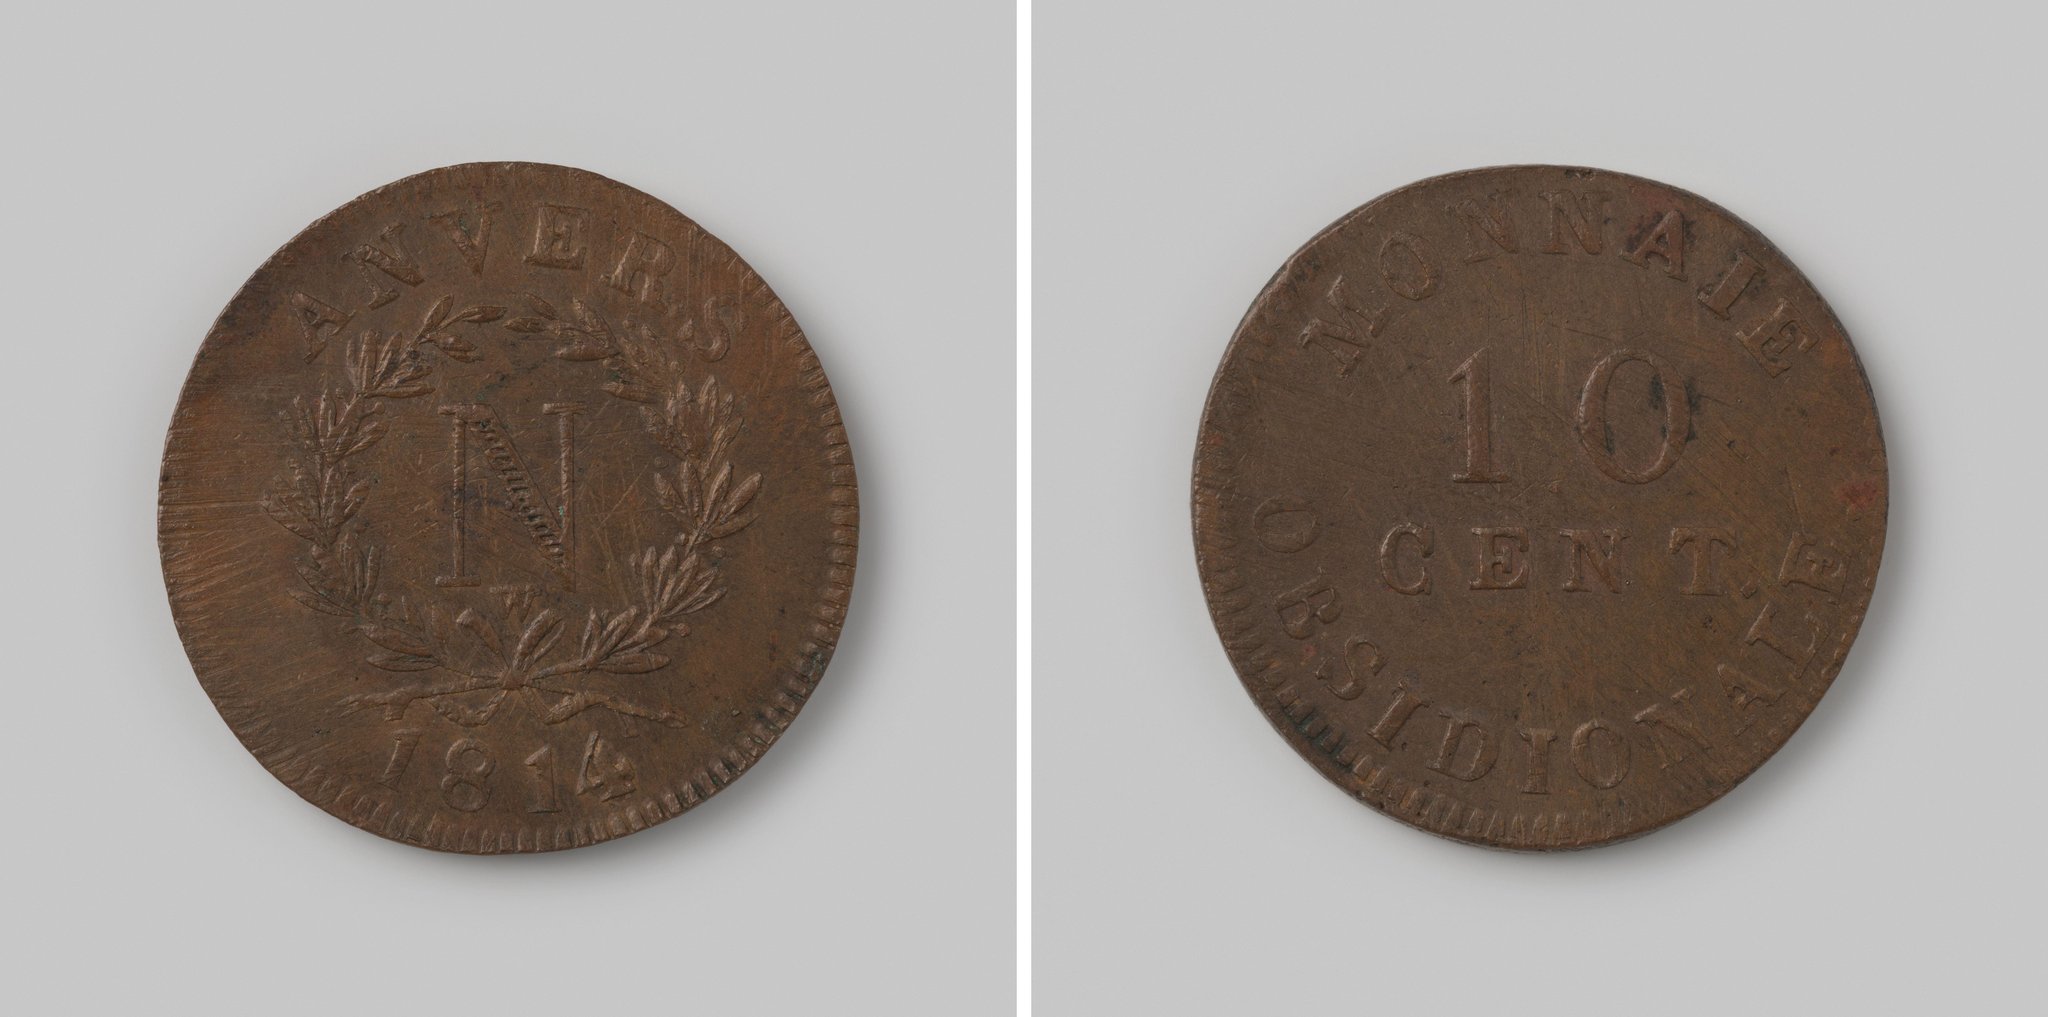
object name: siege coin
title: Antwerpen, Napoleon, noodmunt van 10 centimes, 1814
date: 1814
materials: bronze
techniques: striking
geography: antwerp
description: Bronzen noodmunt. Voorzijde: binnen een krans van twee samengebonden takken letter N. Bovenaan plaats-aanduiding: Anvers en onderaan jaartal. Keerzijde: waarde-aanduiding: 10 cent. in twee regels. Omschrift: Monnaie Obsidionale.